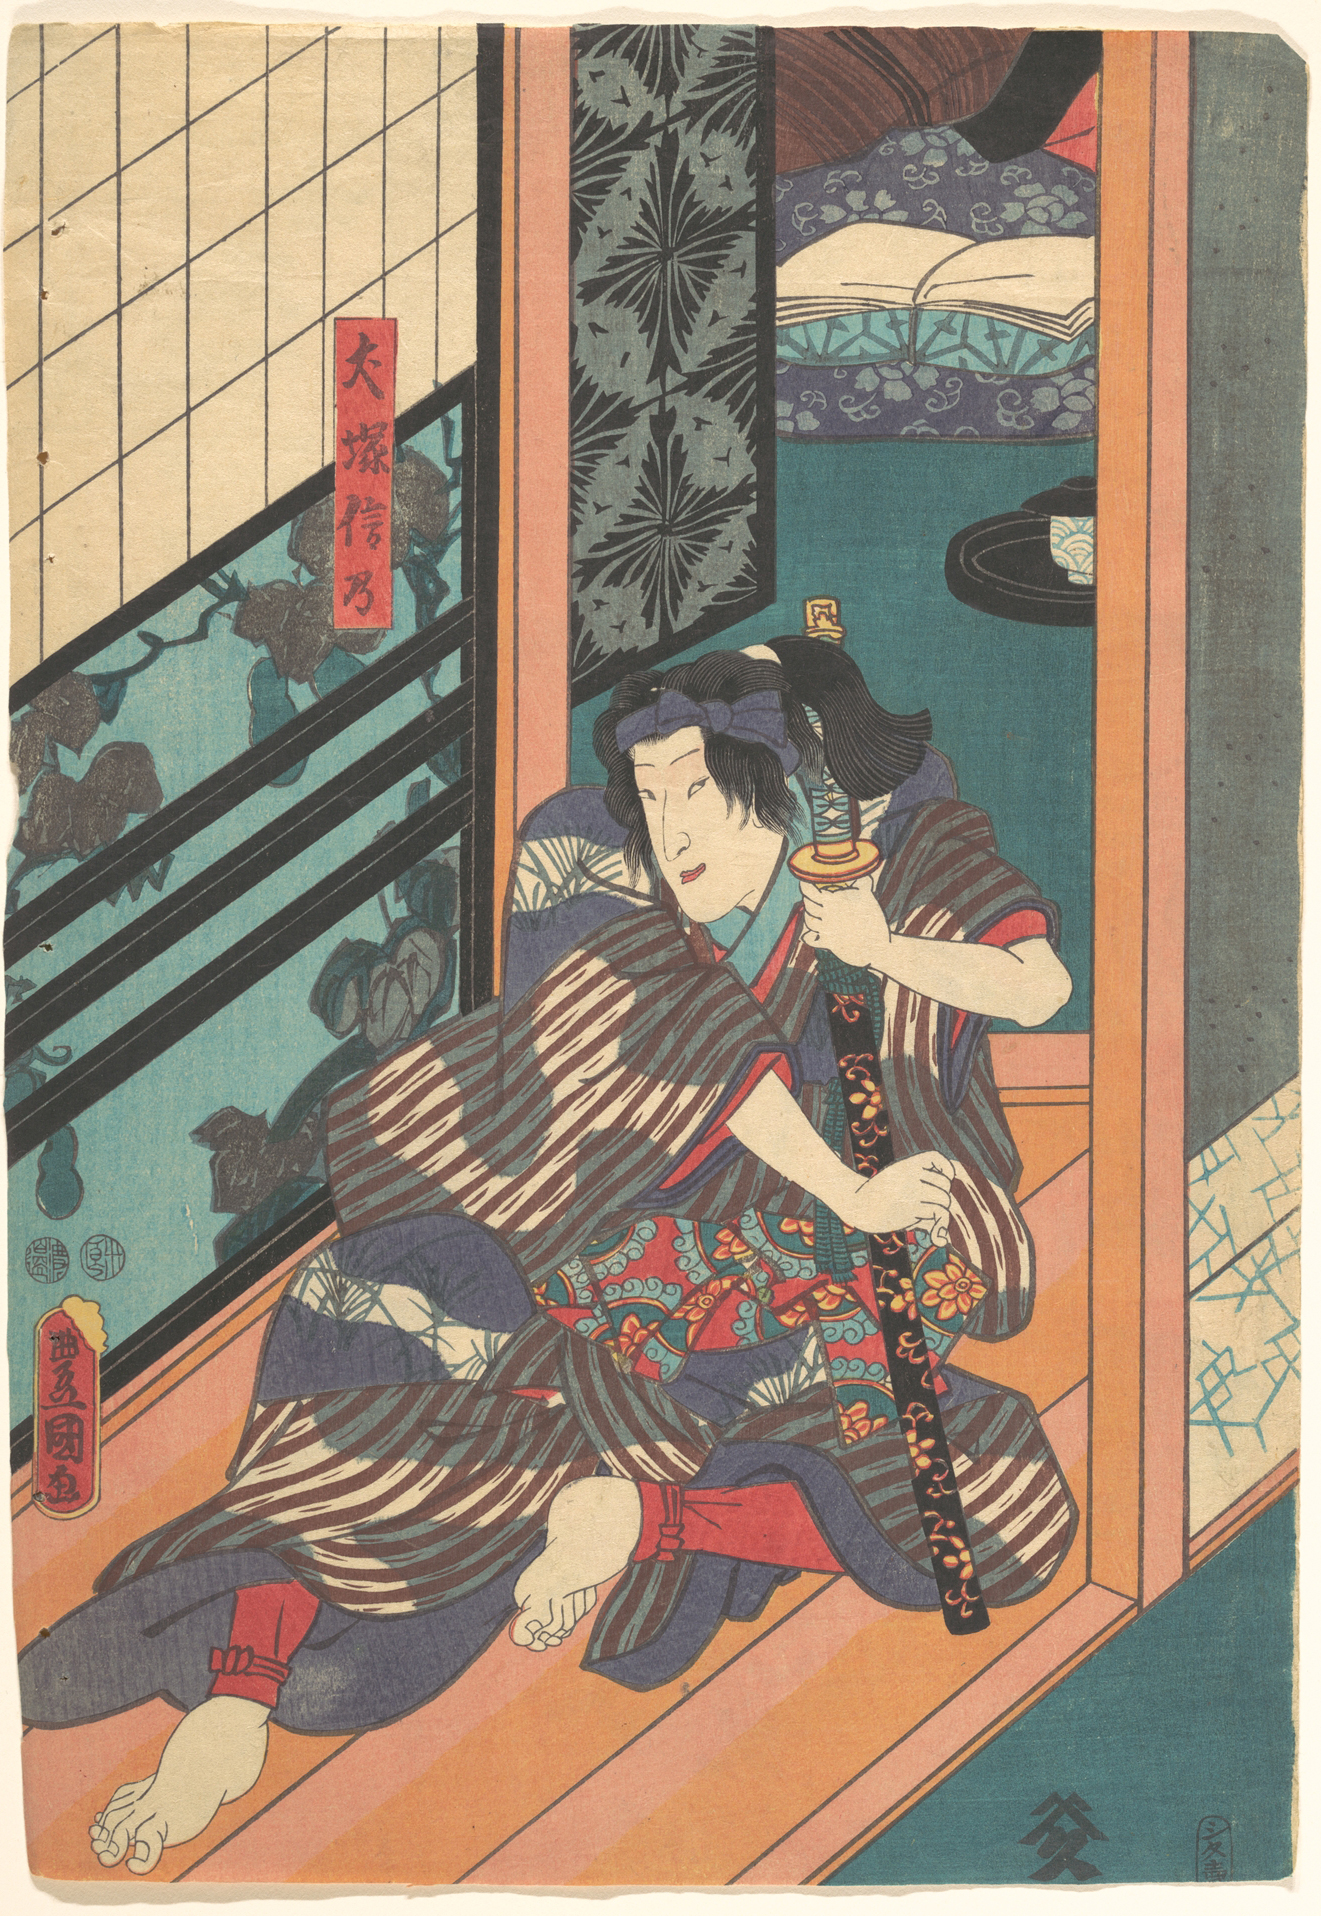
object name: print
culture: japanese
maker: utagawa kunisada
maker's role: artist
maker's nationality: japanese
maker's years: 1786-1864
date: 1801-1900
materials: ink, paper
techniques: woodblock print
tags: human figures,swords